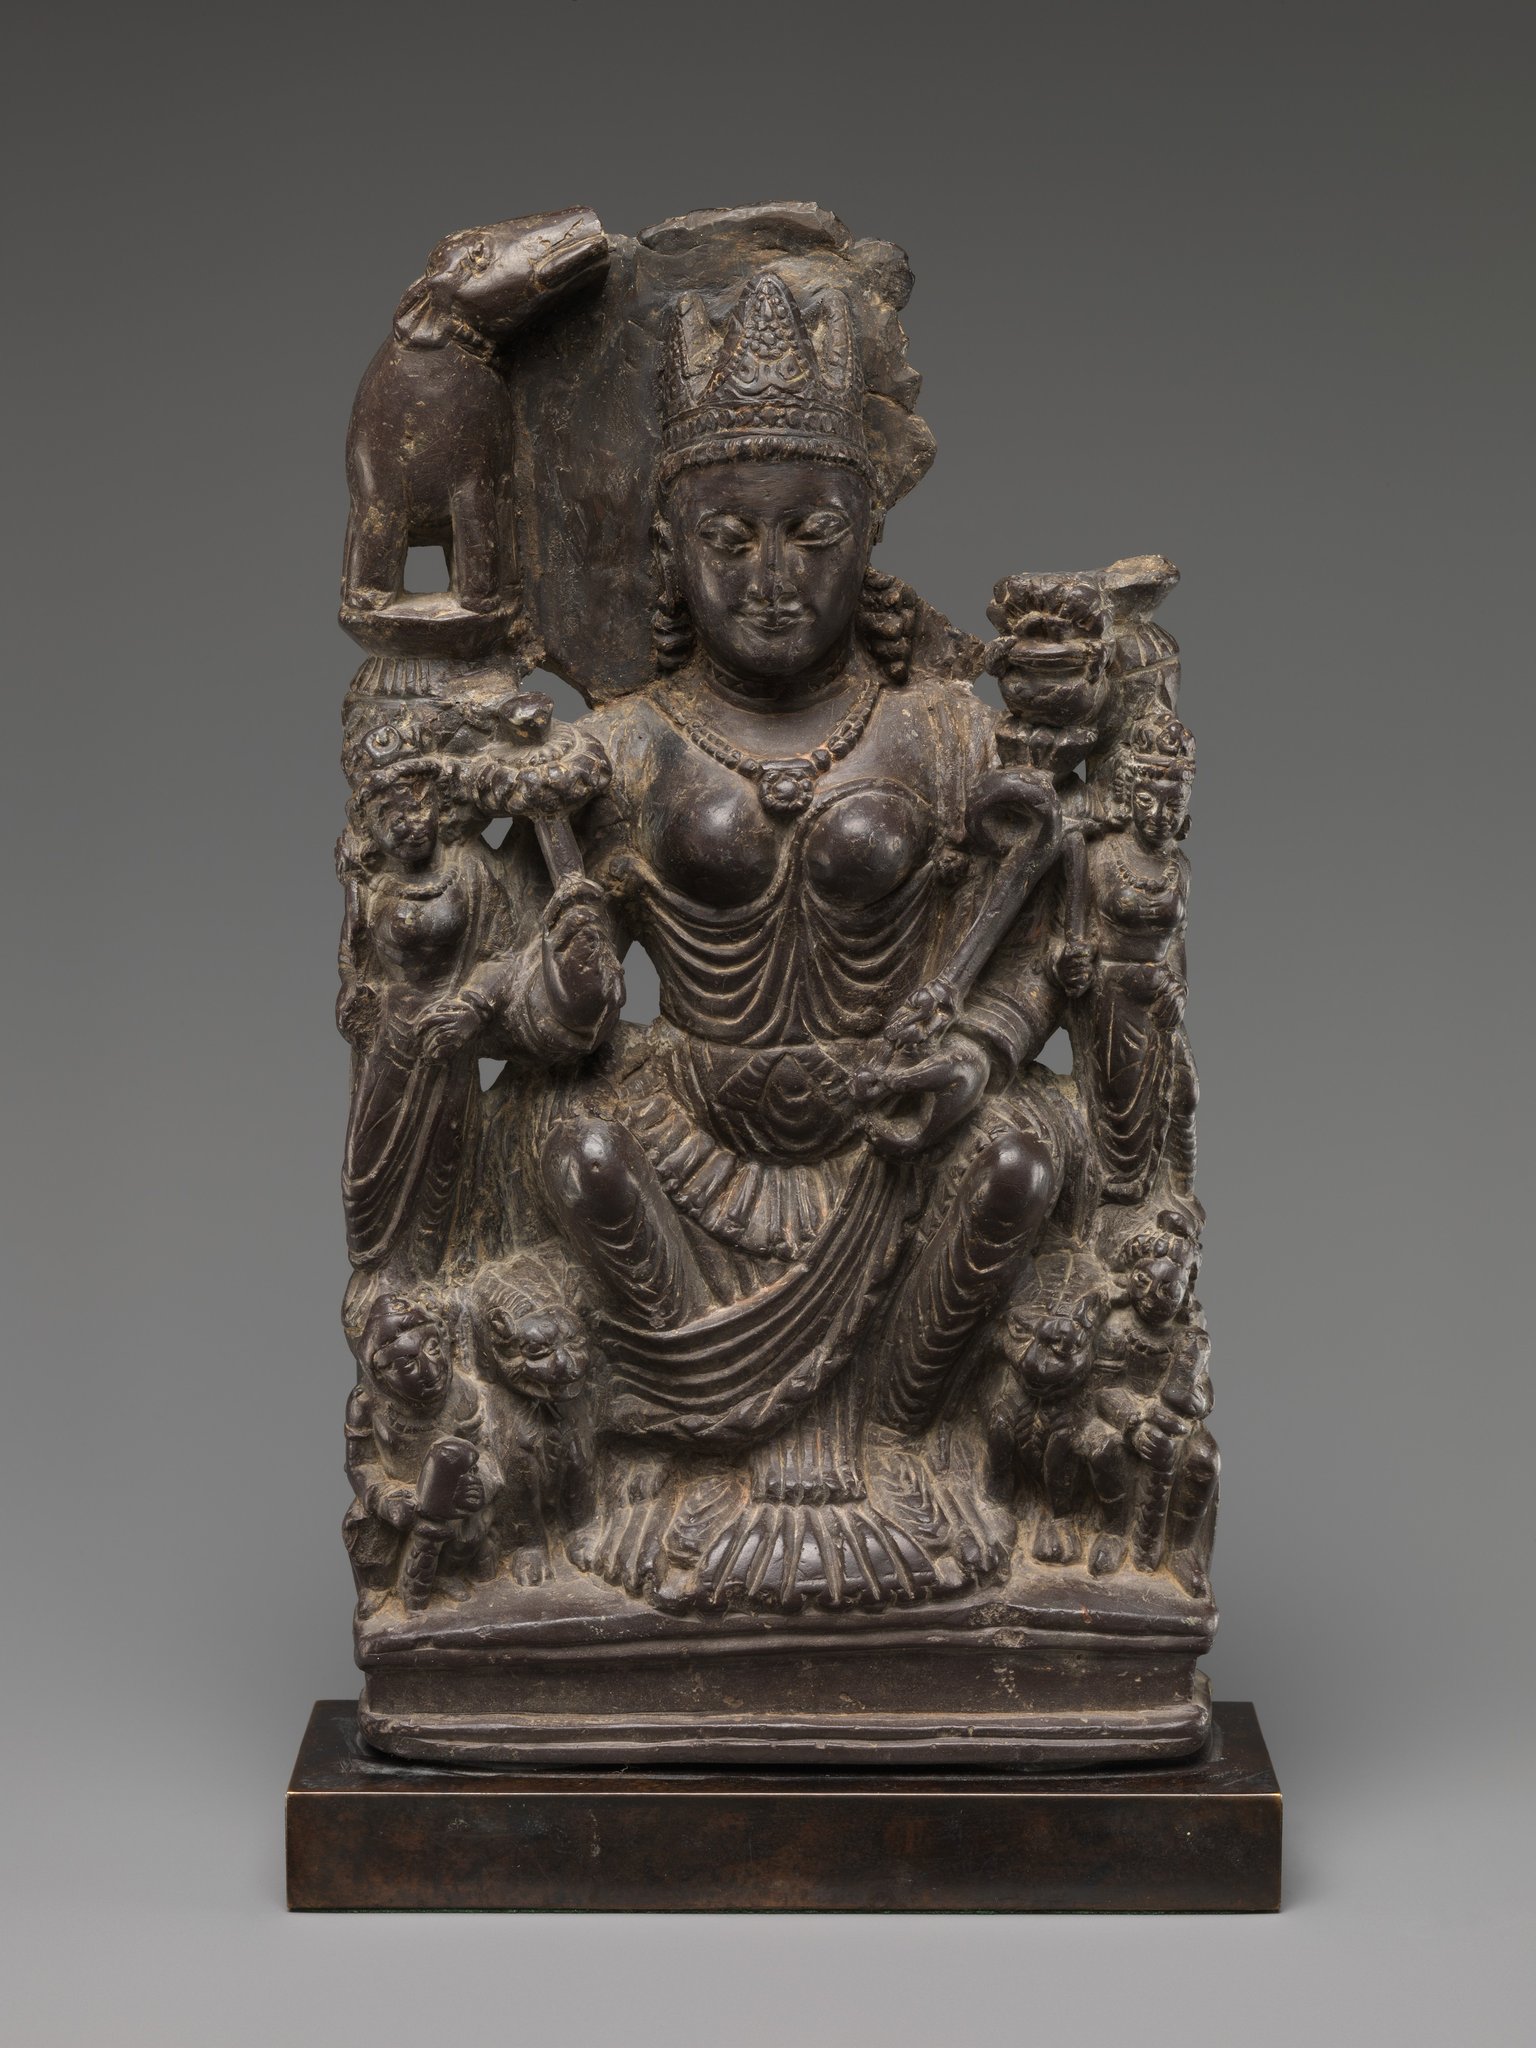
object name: relief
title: Gaja Lakshmi, Goddess of Fortune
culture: kashmiri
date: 501-600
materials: stone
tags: kashmir,goddess,hinduism